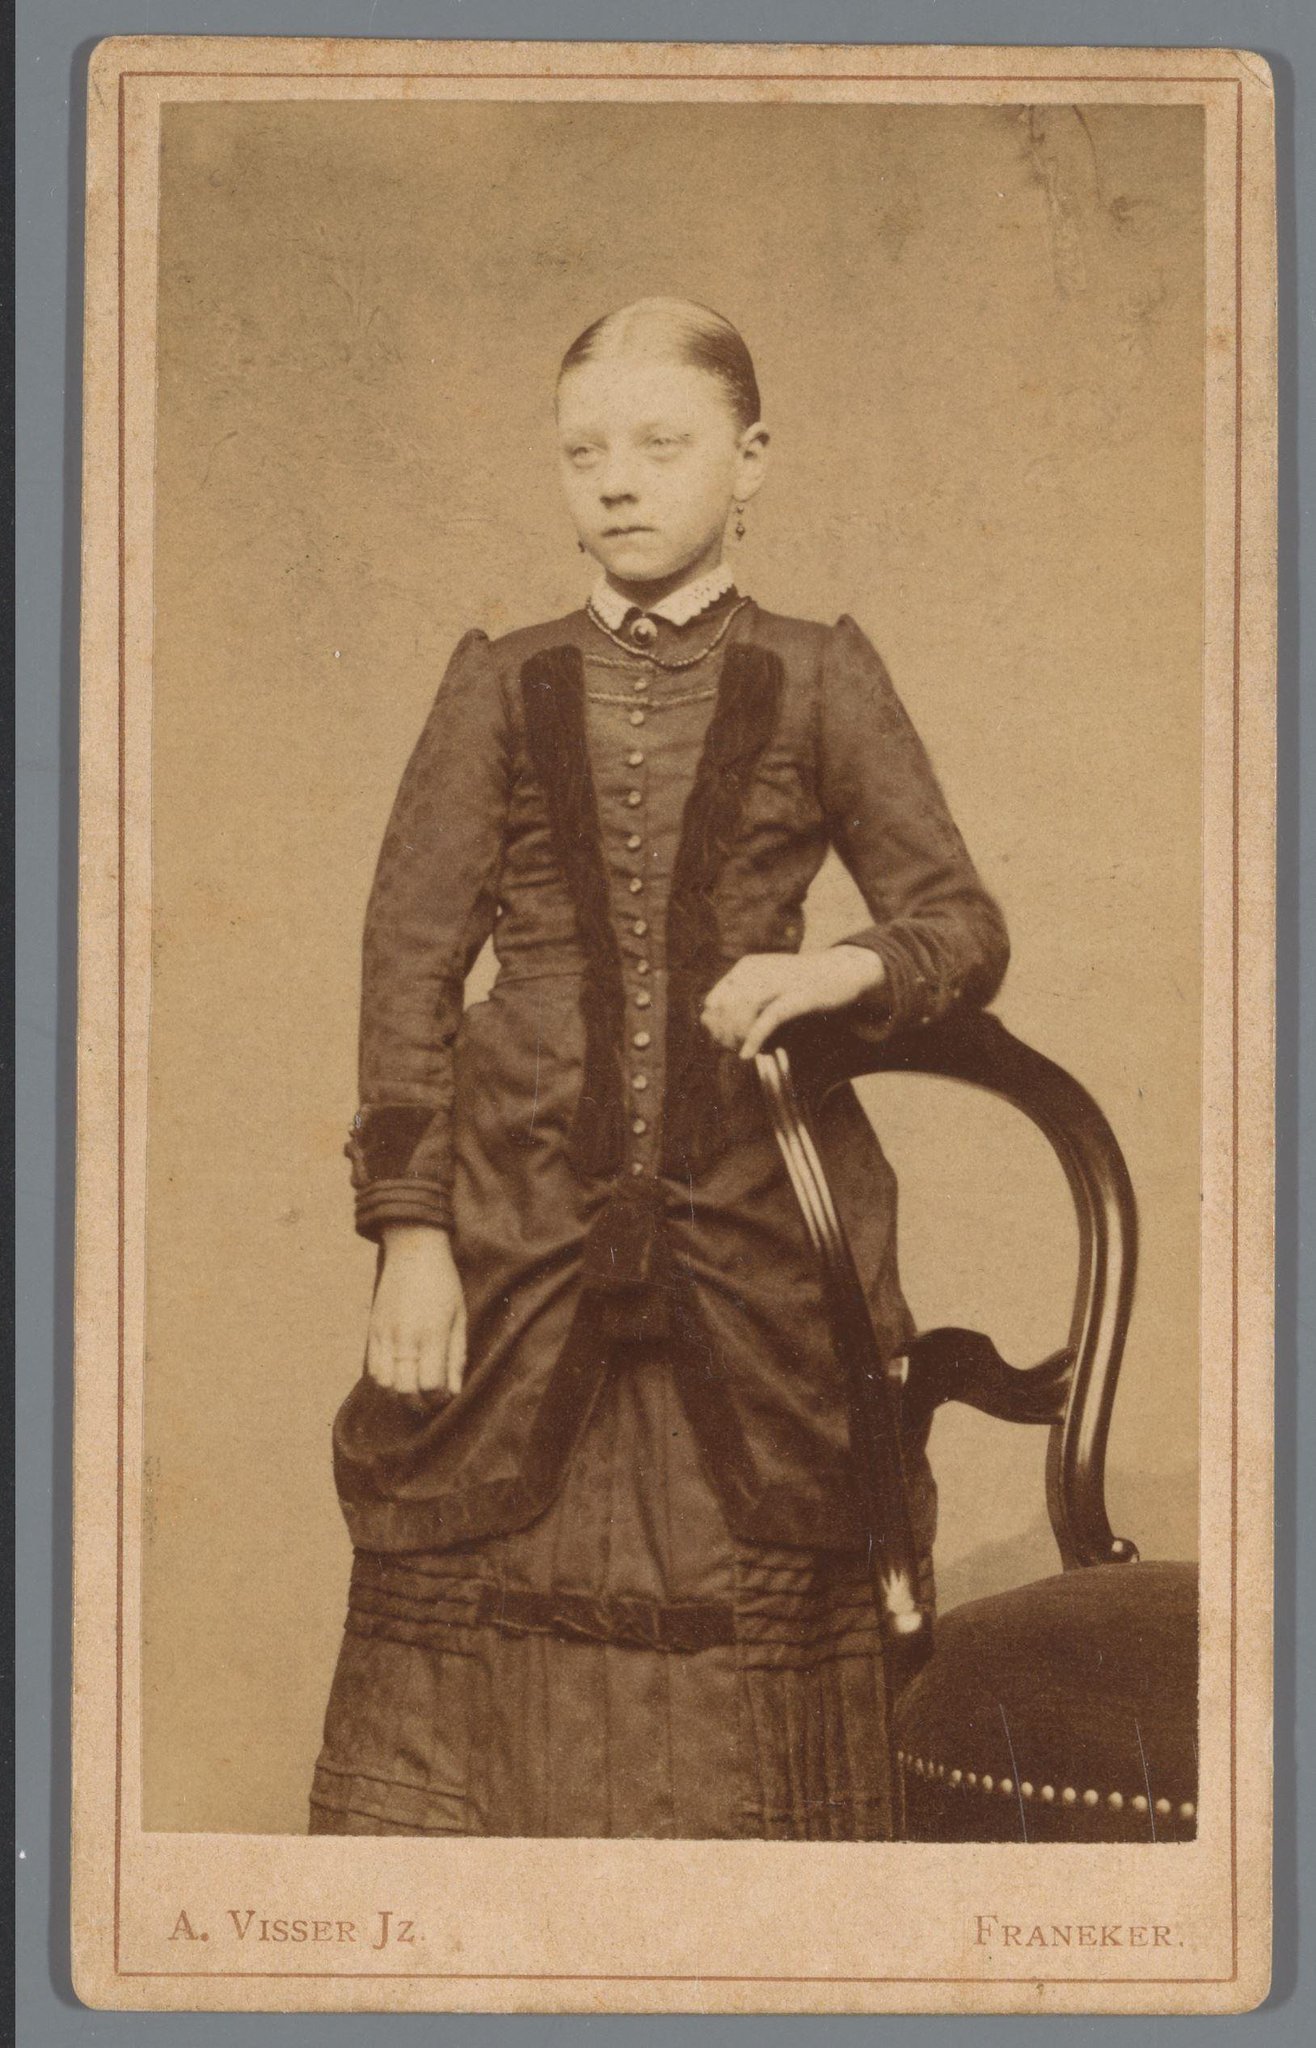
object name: carte de visite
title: Portret van Anna Mulder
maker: a. visser jzn.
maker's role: fotograaf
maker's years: 1847-1926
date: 1885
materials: cardboard, paper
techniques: albumen print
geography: franeker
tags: historical persons, girl (child between toddler and youth)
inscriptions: inscription: ‘A. Visser Jz. Franeker’, inscription: ‘Photographie Artistique/ van/ A. Visser Jz/ Plat TN 102./ Franeker./ Portretten kunnen op iedere groote/ nabesteld worden.’, inscription: ‘Anna Mulder’, monogram: ‘AVJz’